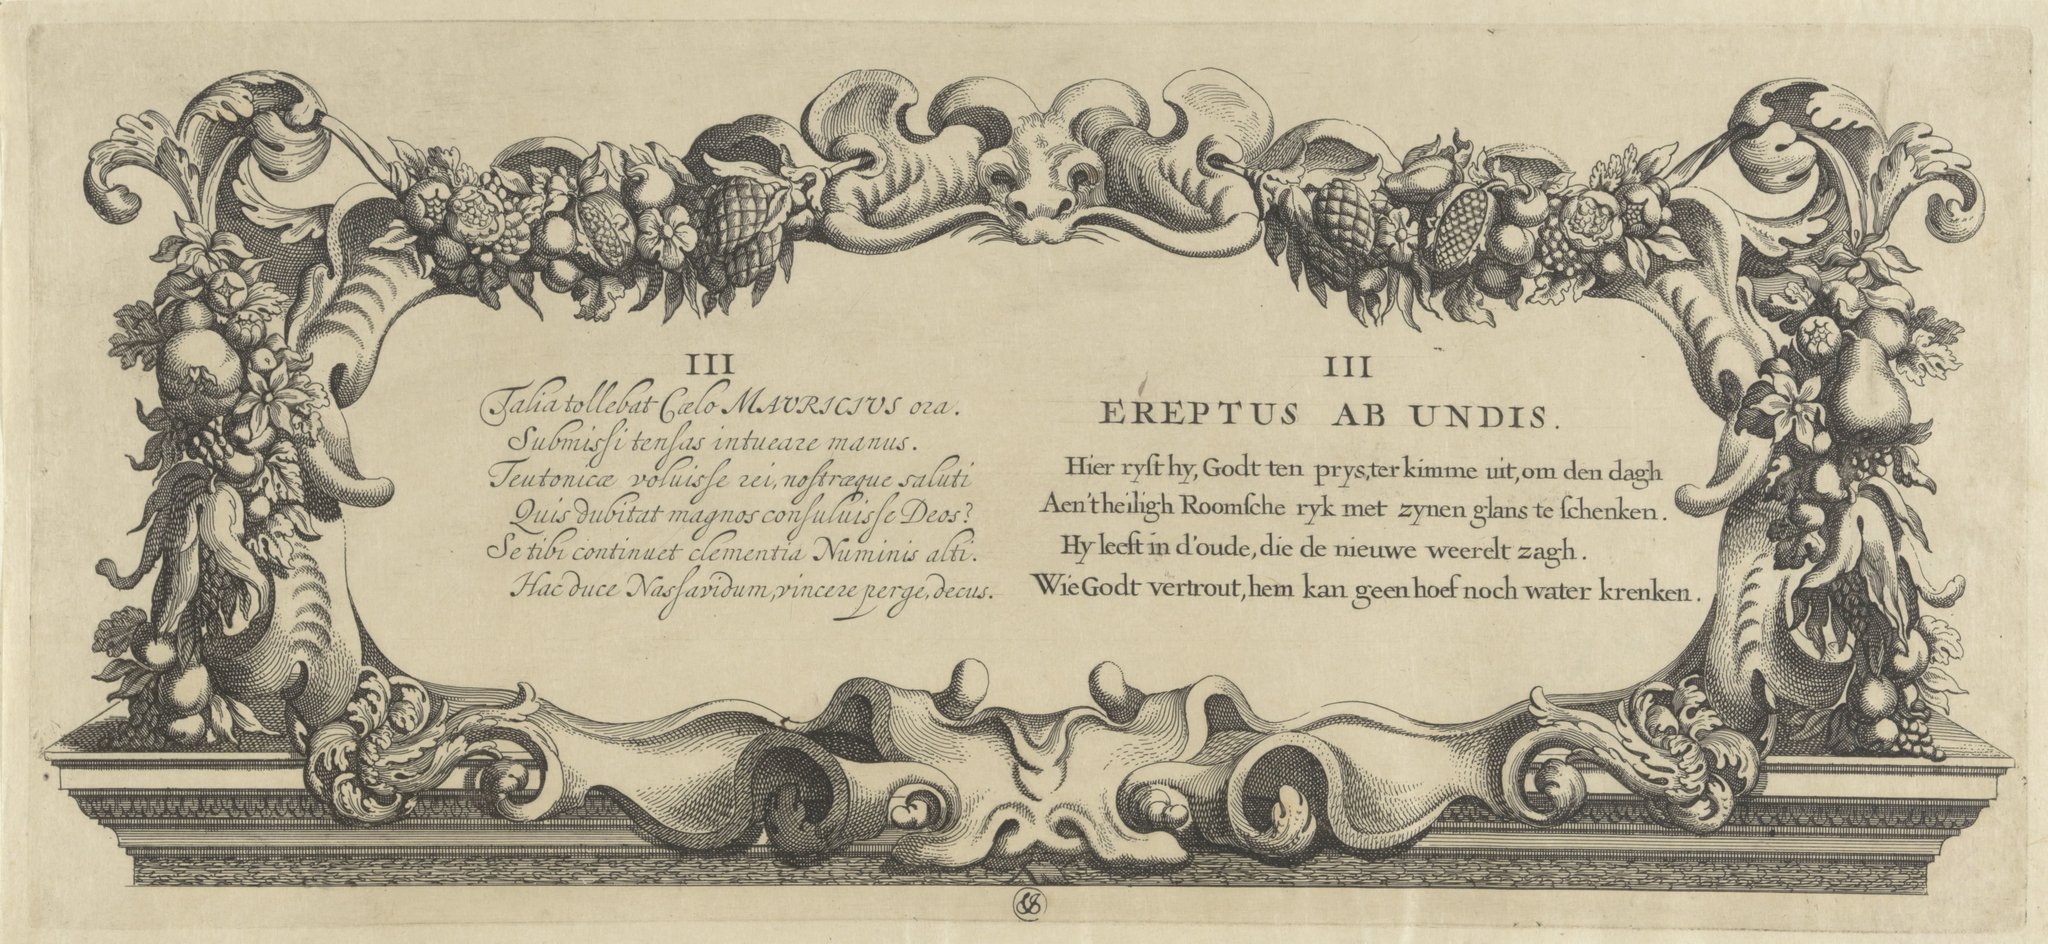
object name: print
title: III Ereptus ab undis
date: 1665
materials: paper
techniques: etching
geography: northern netherlands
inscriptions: collector's mark: Lugt 573, collector's mark: Lugt 12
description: Blad met een cartouche met twee teksten behorend bij de derde plaat met de voorstelling van de dankzegging door graaf Johan Maurits op de brug van Franeker, 6 januari 1665. Cartouche gevormd door een festoenen en ornamenten. Links een vers van zes regels in het Latijn, rechts een vers van 4 regels in het Nederlands.